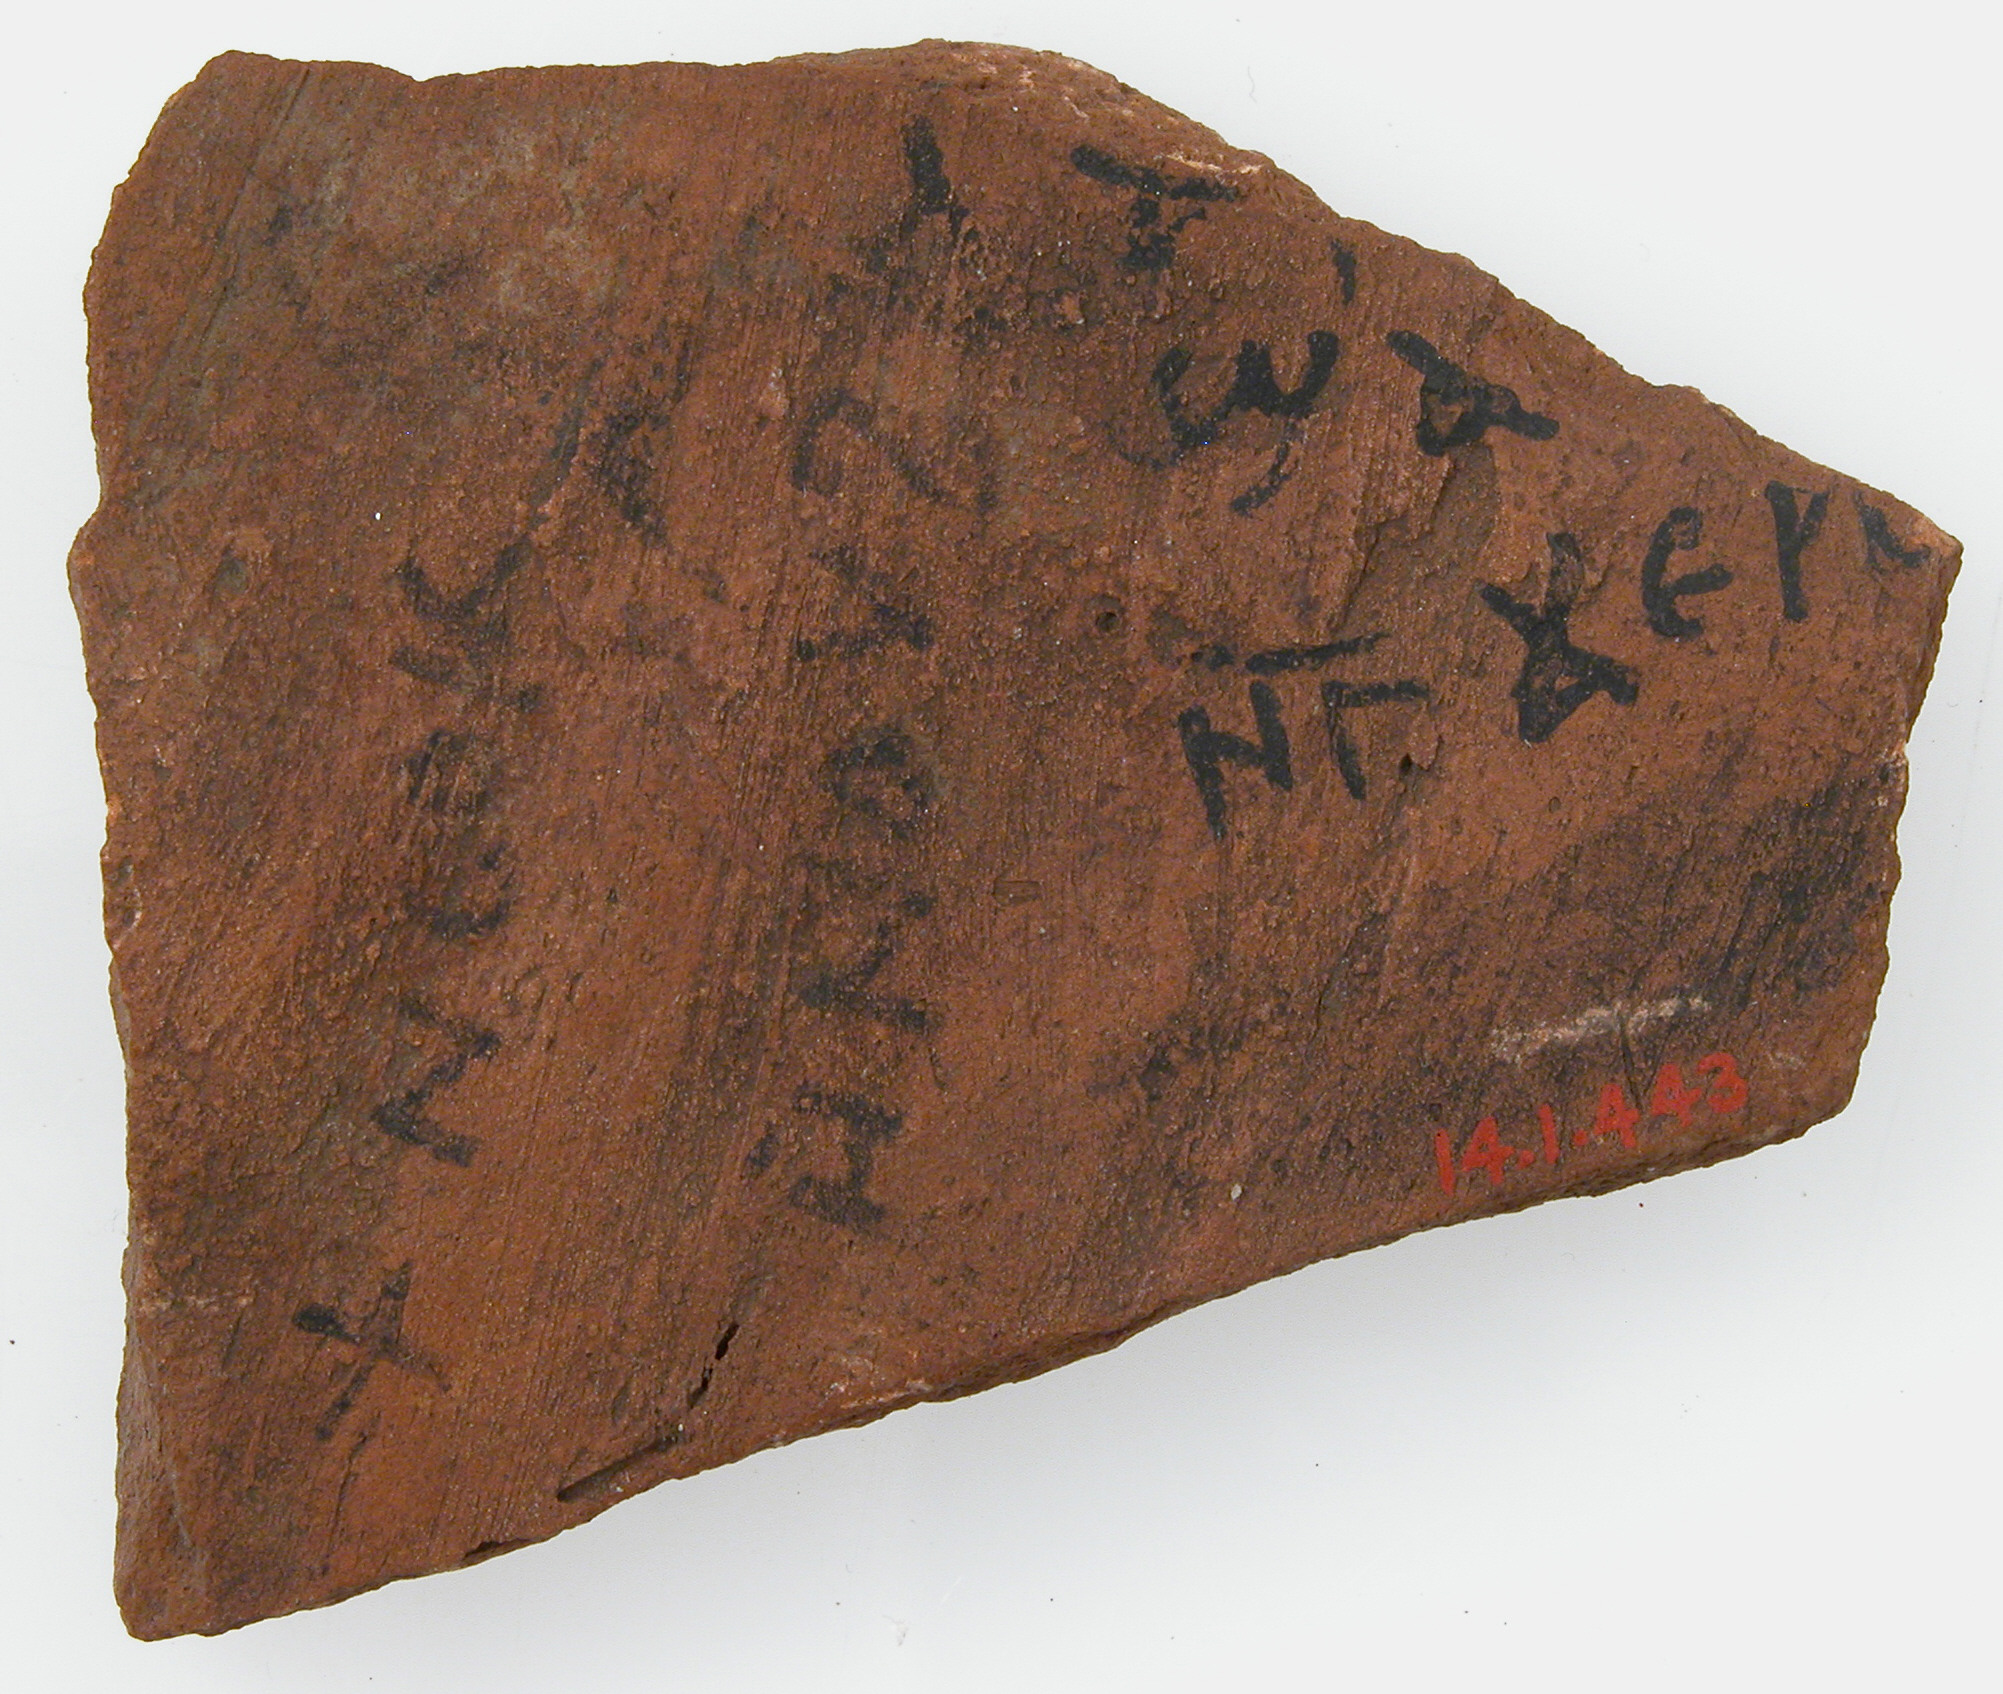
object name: ostrakon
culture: coptic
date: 580-640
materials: ink, pottery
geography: egypt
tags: coptic,documents